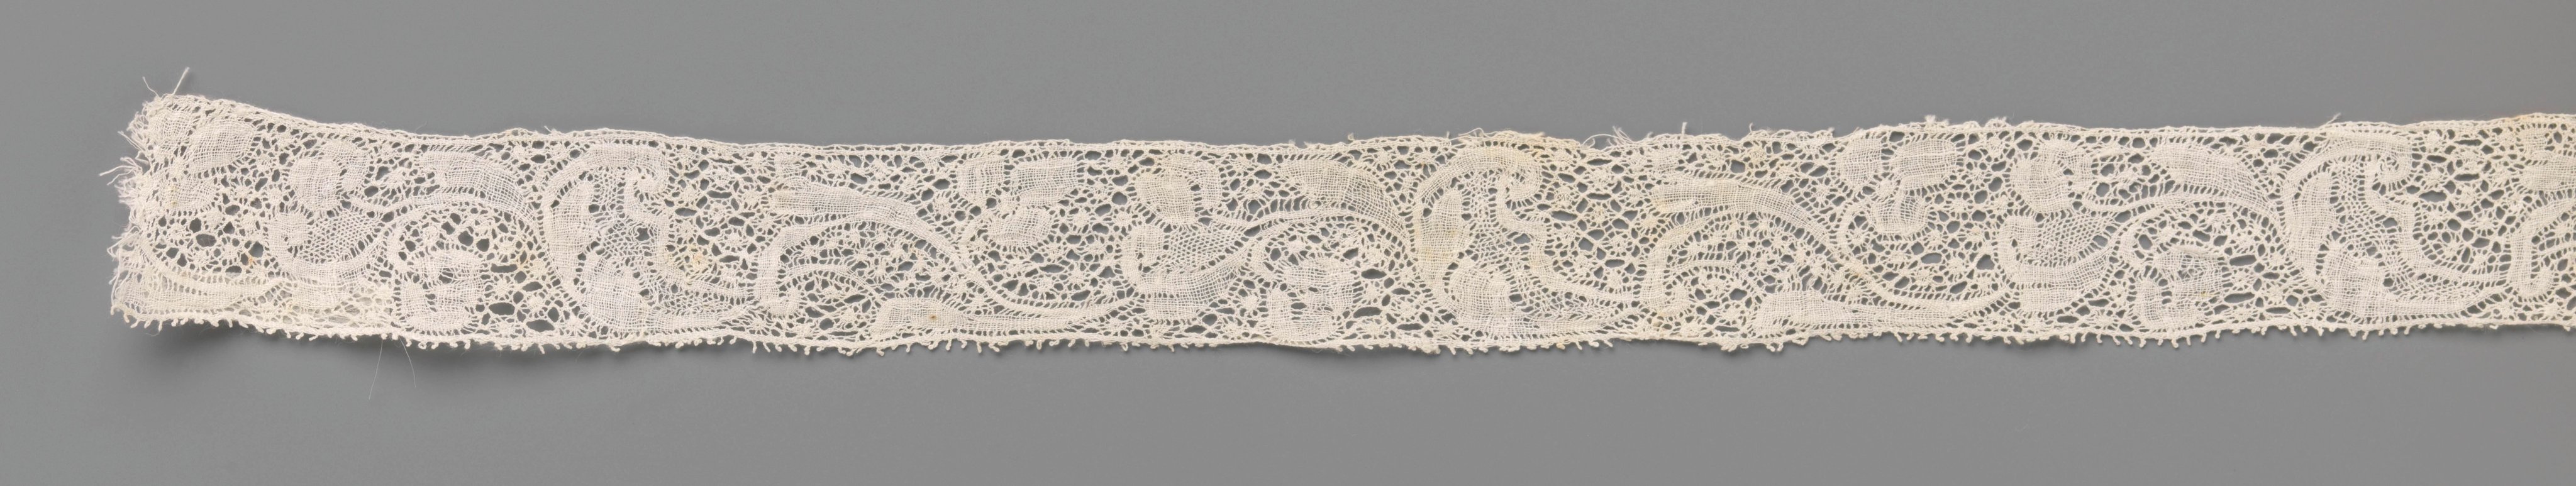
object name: strip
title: Strook kloskant met een aaneenschakeling van gebogen bloemstelen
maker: Anonymous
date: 1750-1760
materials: linen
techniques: lace, snowflake filling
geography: southern netherlands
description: Strook naturelkleurige kloskant: Binche-kant. Twee gebogen bloemstelen met brede bladeren en verschillende bloemen vormen aaneenschakeld een golvend patroon. De motieven zijn met elkaar verbonden door een siergrond, een sneeuwvlokkengrond. De motieven zijn gemaakt in linnenslag met opengewerkte randjes en in netslag. Boven- en onderzijde zijn recht afgewerkt, waarbij de onderzijde is voorzien van picots.